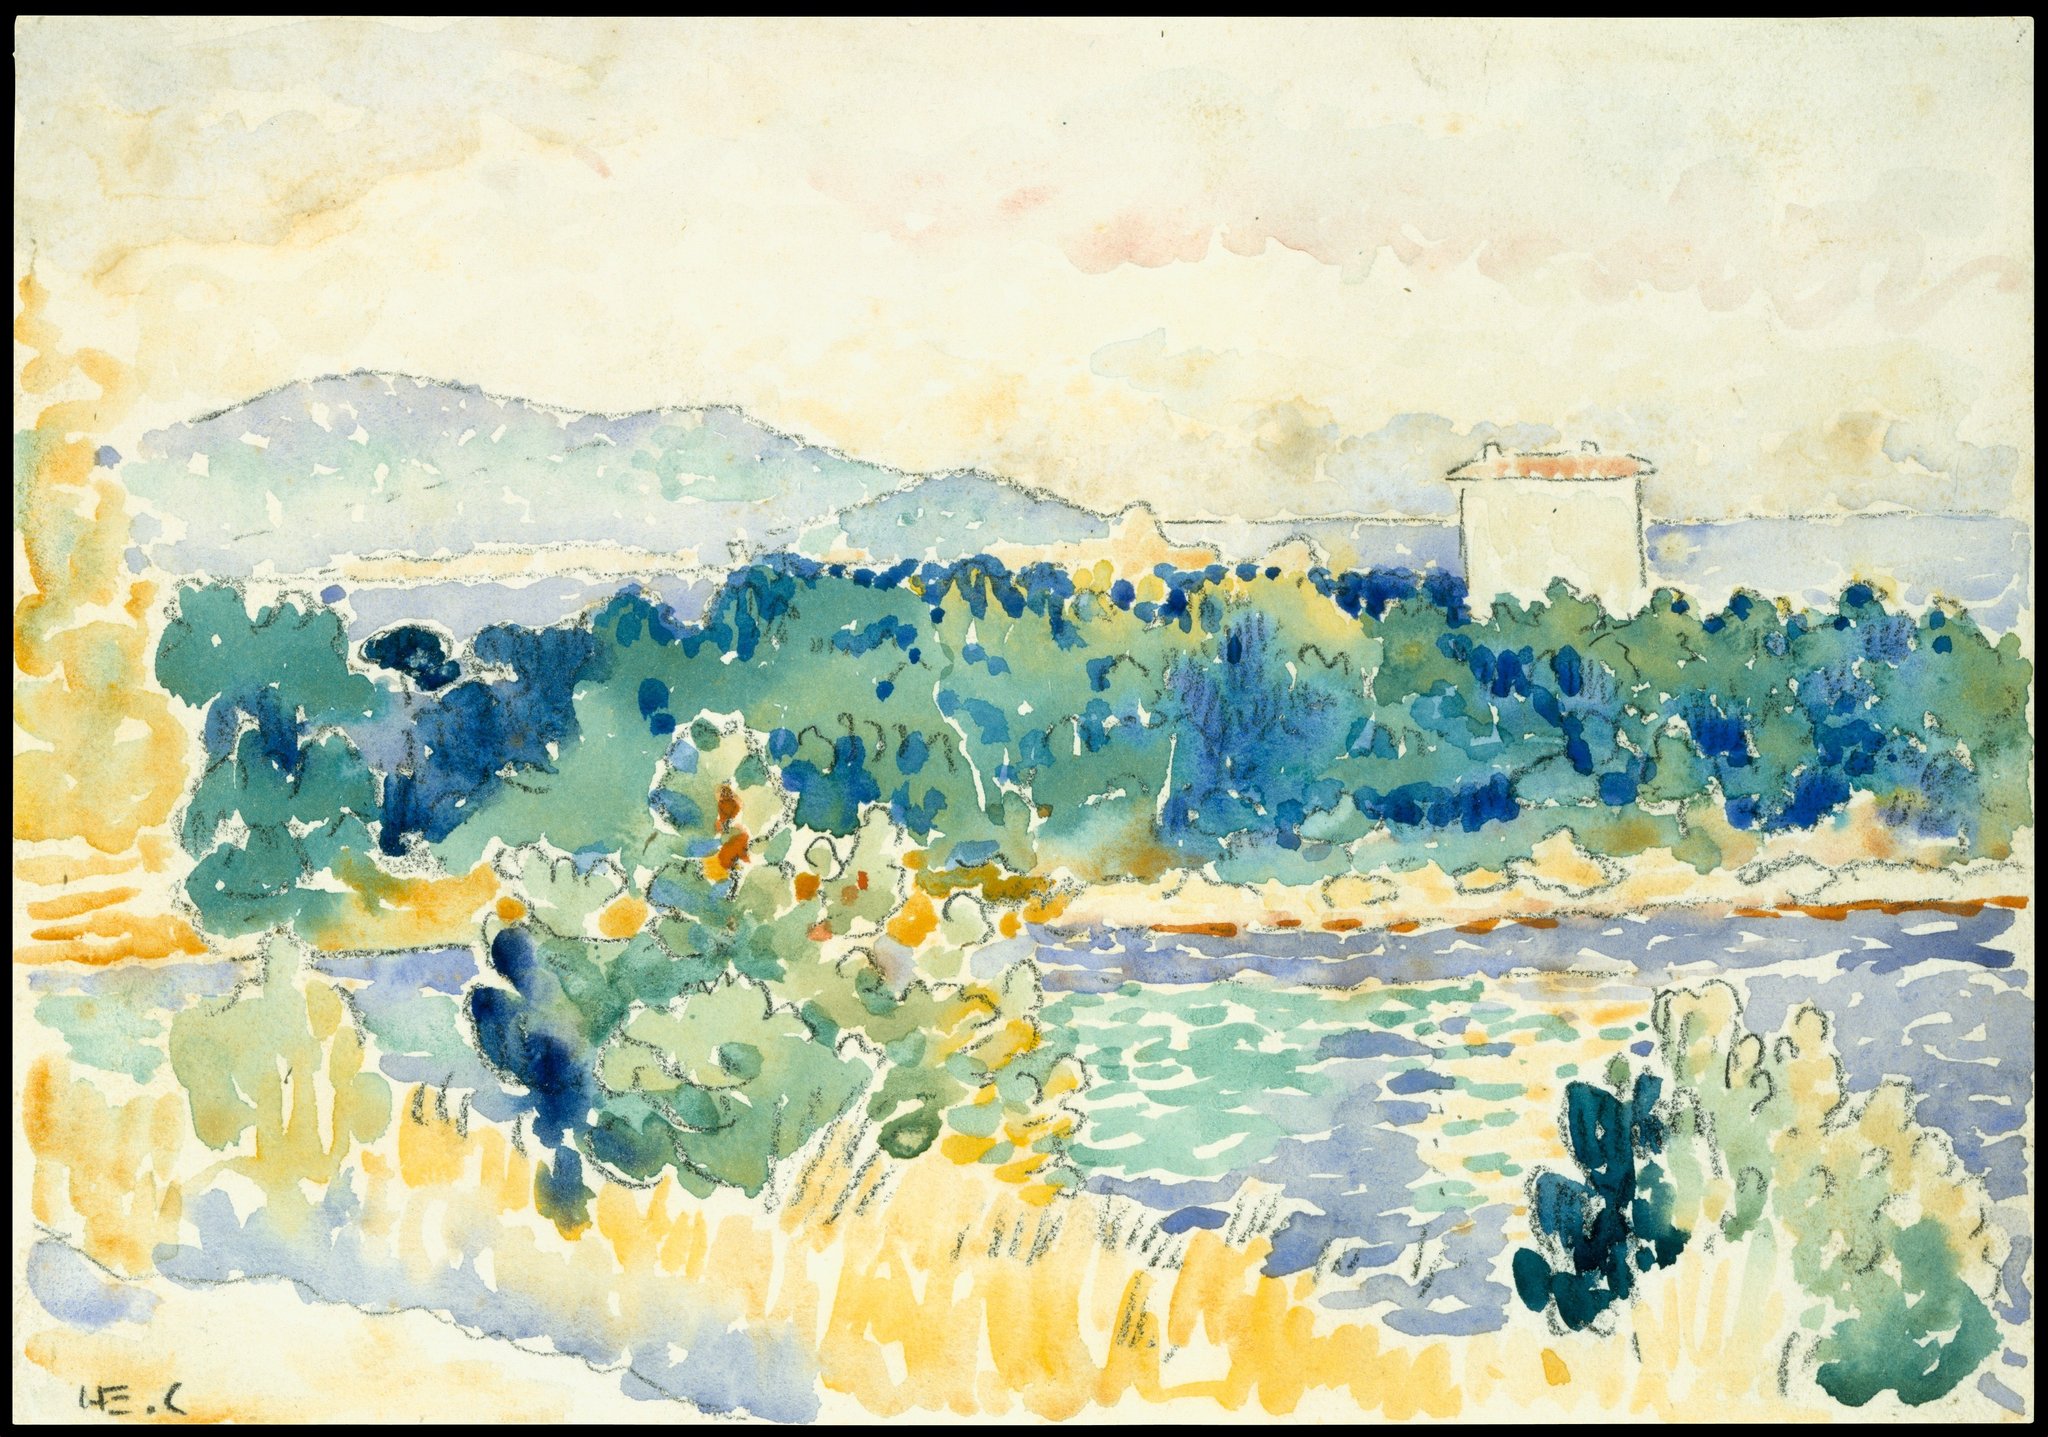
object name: drawing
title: Mediterranean Landscape with a White House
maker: henri-edmond cross (henri-edmond delacroix)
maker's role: artist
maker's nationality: french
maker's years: 1856-1910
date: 1900-1905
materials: graphite, watercolor, paper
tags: landscapes